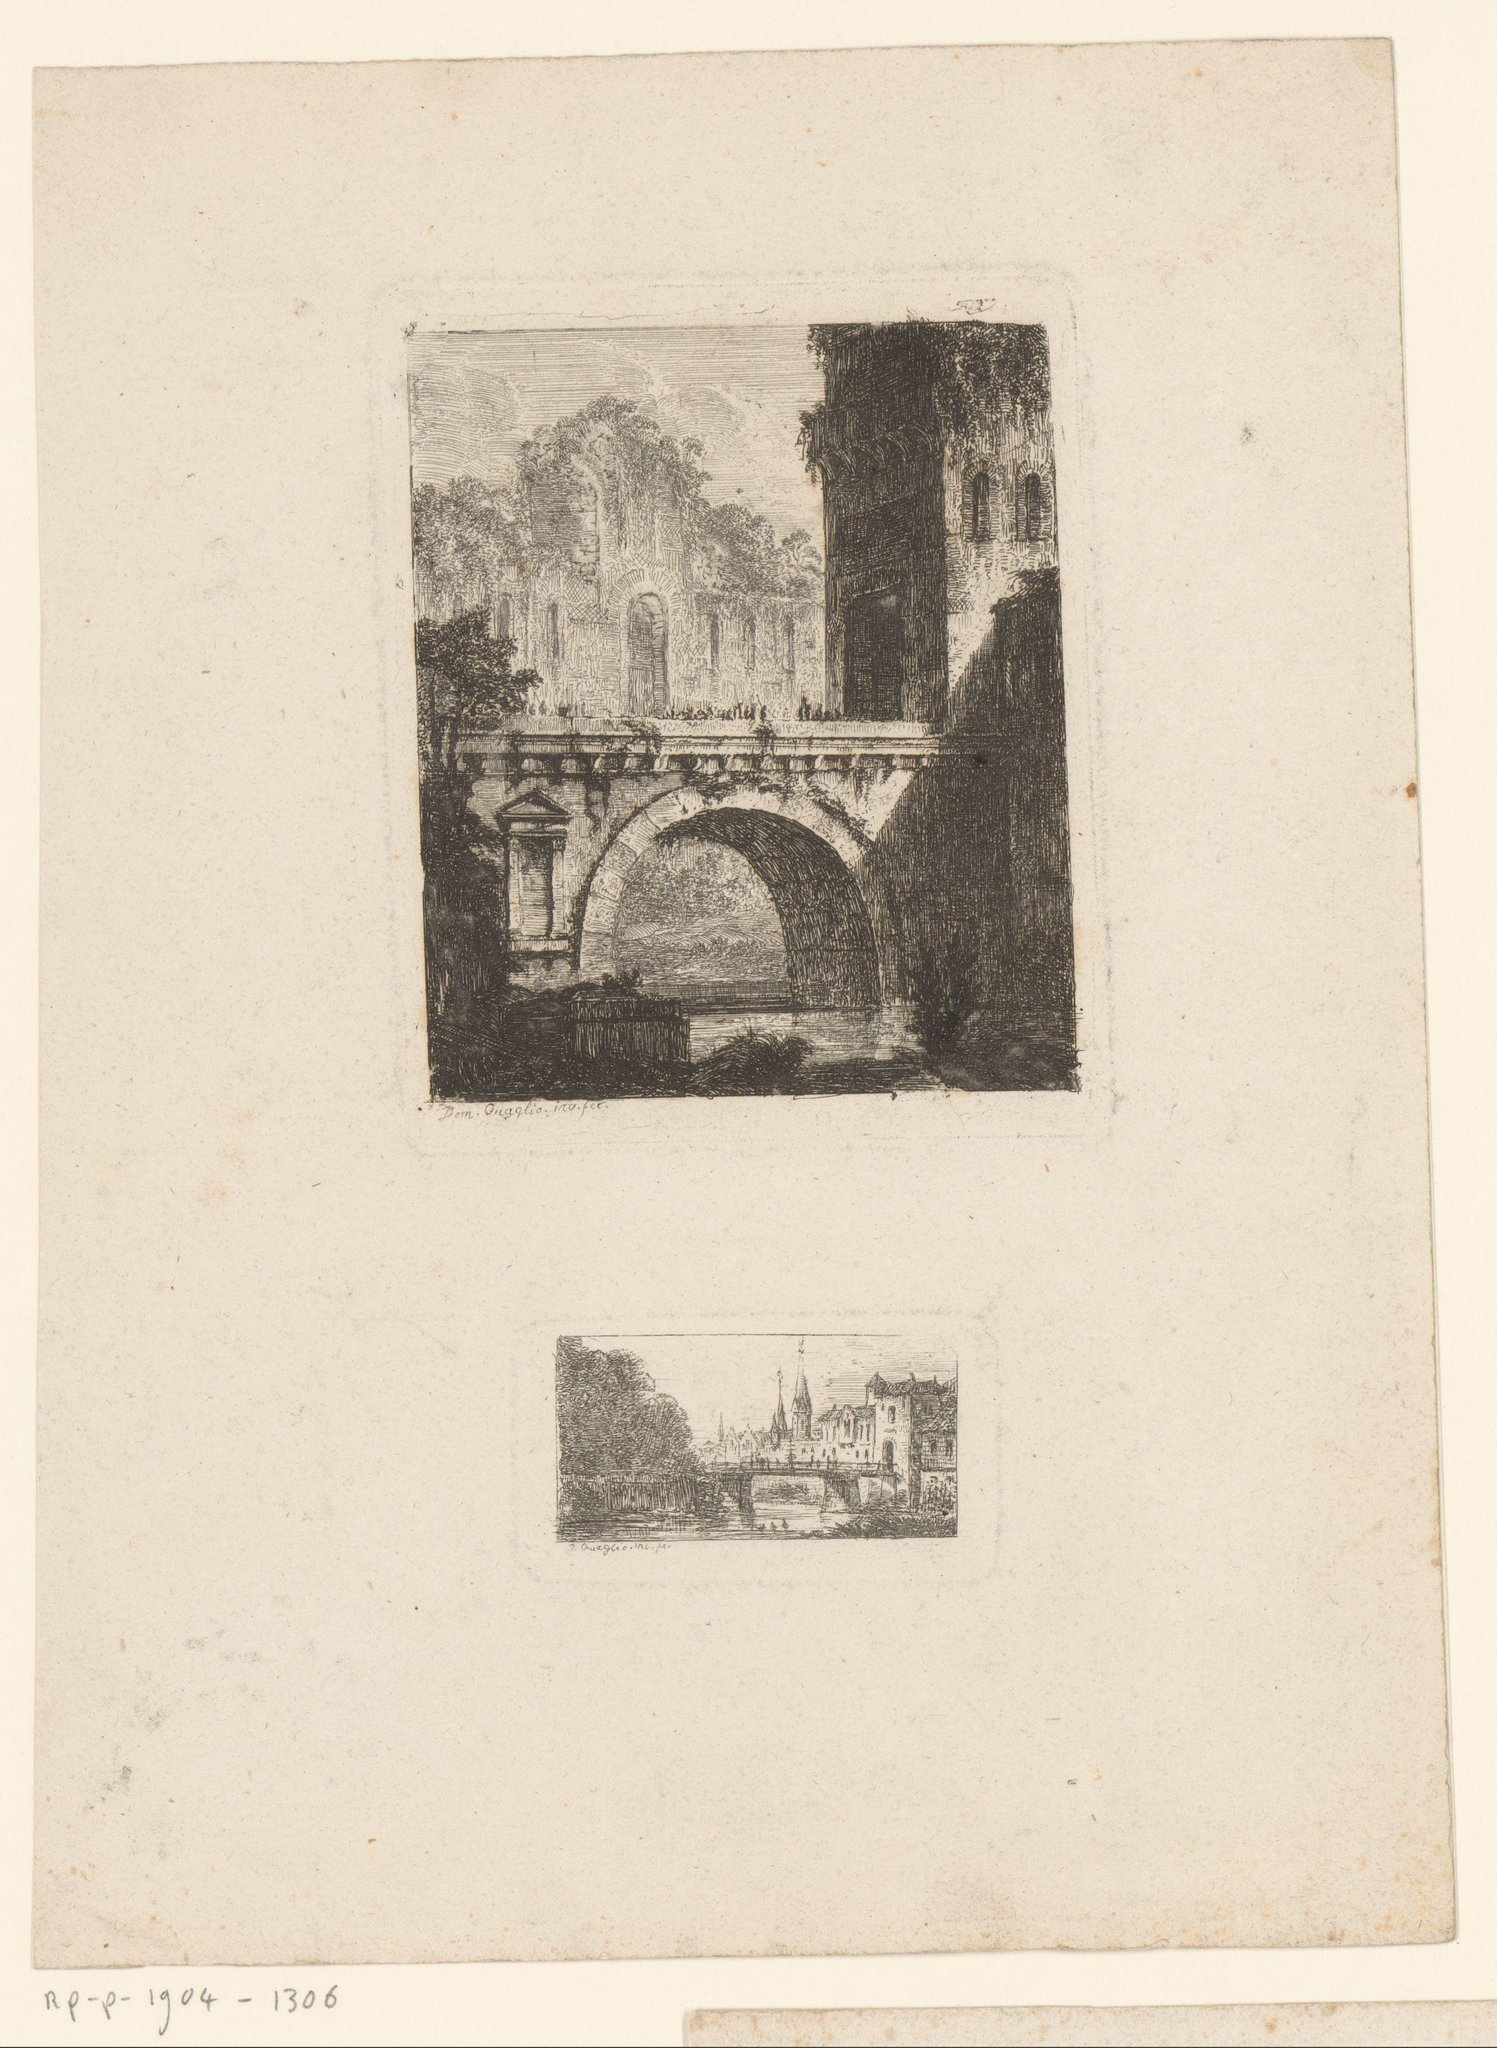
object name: print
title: Kasteelpoort en een stadspoort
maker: domenico quaglio (ii)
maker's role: painter, print maker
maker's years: 1787-1837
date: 1796-1837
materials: paper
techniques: etching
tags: city-view, and landscape with man-made constructions, city-gate - ii - ideal city, gate, entrance, village-gate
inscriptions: collector's mark: Lugt 2228, collector's mark: Lugt 2228